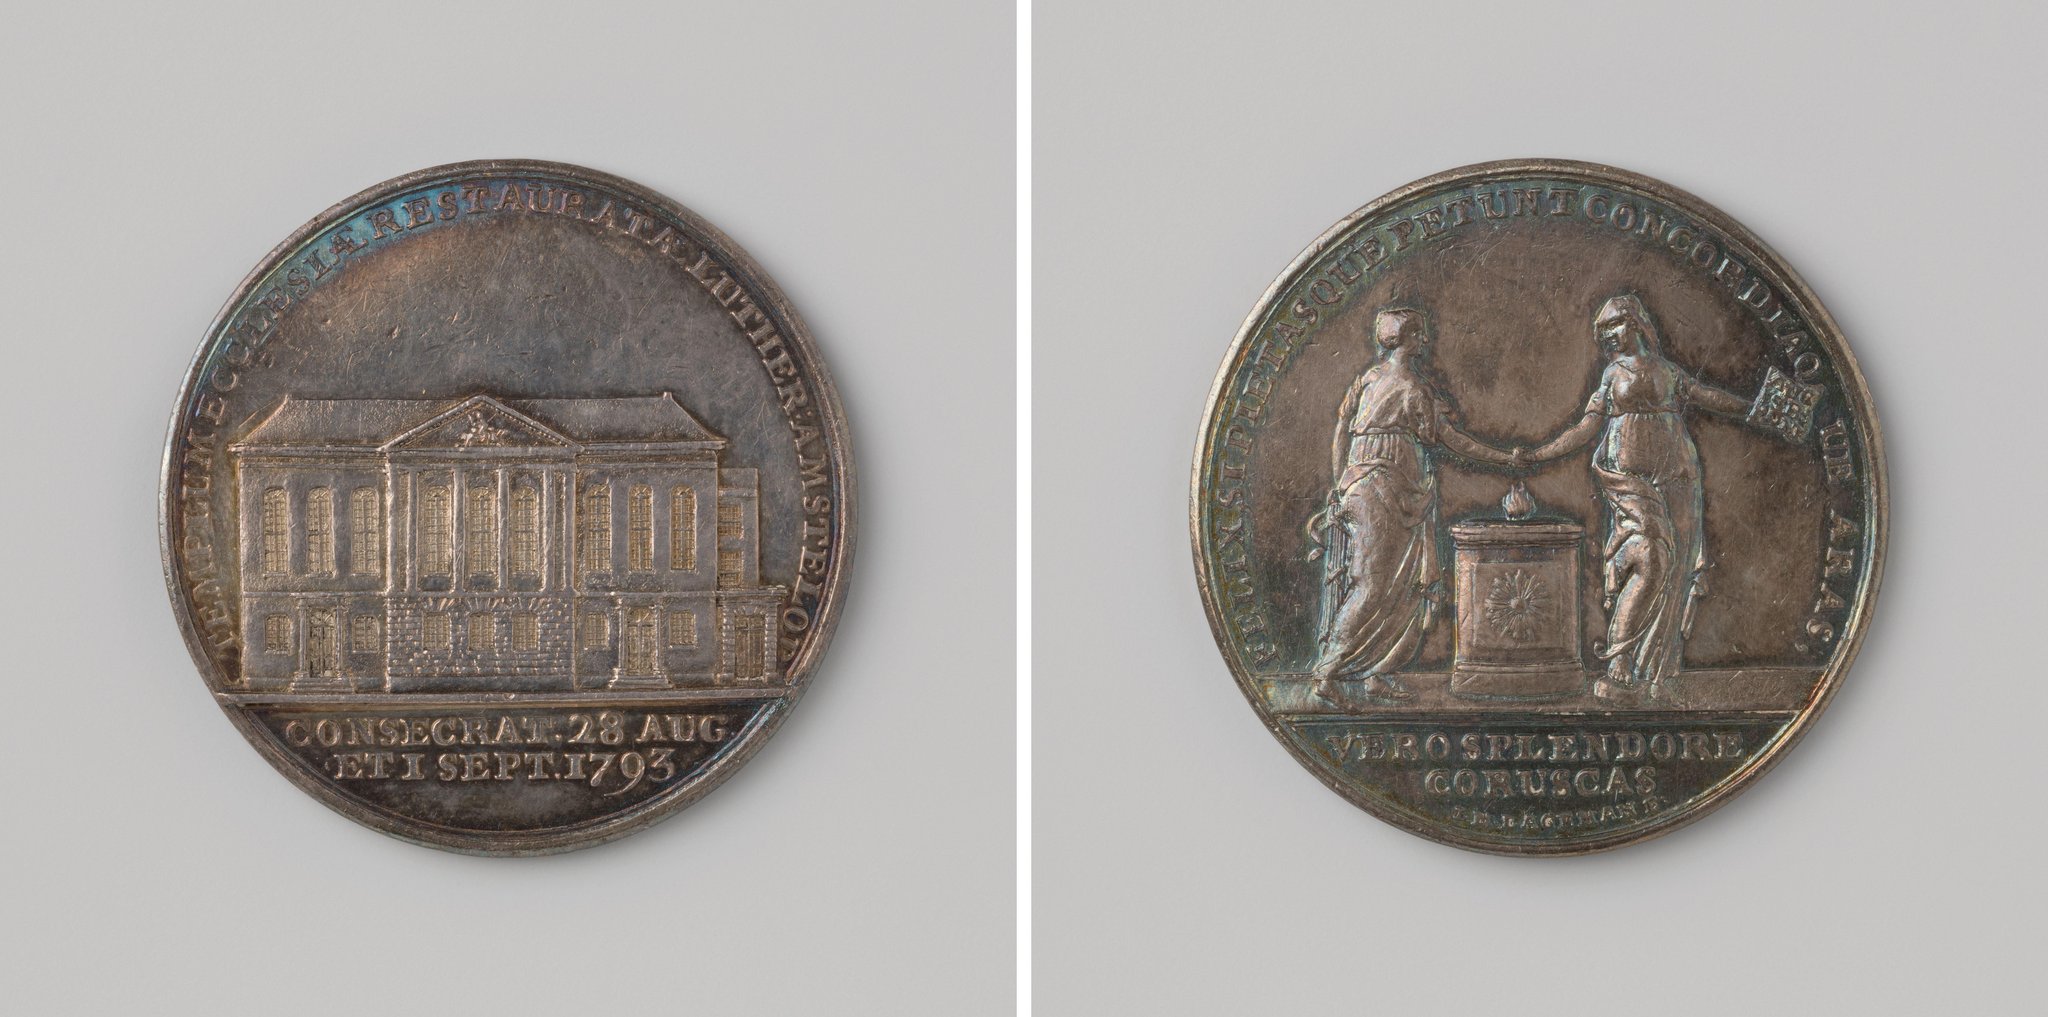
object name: history medal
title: Inwijding van de kerk van de Herstelde Lutherse gemeente te Amsterdam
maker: johannes michiel lageman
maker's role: silversmith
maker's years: 1735-1809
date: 1793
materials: silver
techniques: striking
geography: amsterdam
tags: hersteld evangelisch-lutherse kerk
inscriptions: caption: ‘VERO SPLENDORE/ CORUSCAS’, circumscription: ‘FELIX SI PIETASQUE PETUNT CONCORDIAQUE ARAS:’, caption: ‘CONSECRAT. 28 AUG./ ET 1 SEPT. 1793’, signature: ‘I.M. LAGEMAN F.’, circumscription: ‘TEMPLUM ECCLESIÆ RESTAURATÆ LUTHER: AMSTELOD’